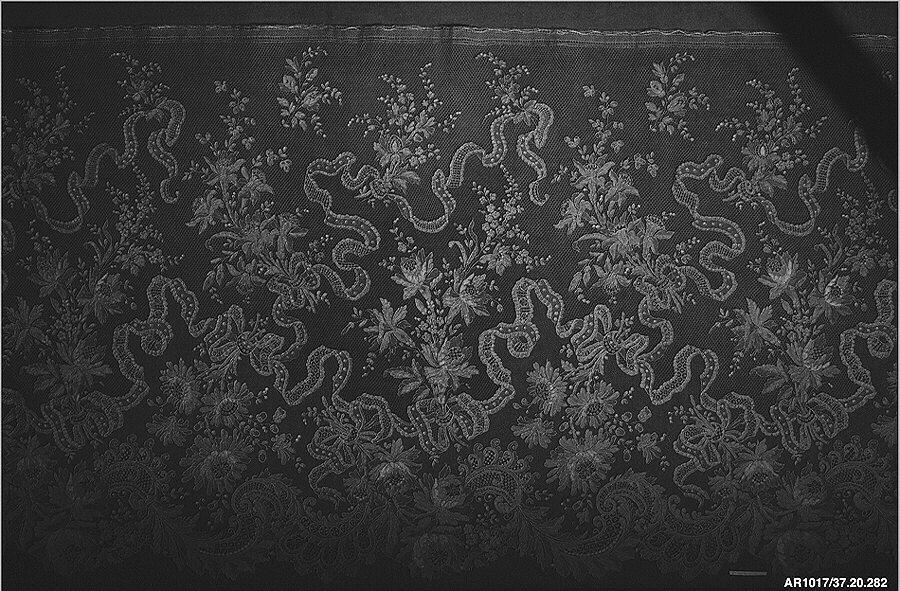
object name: flounce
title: Flounce (one of a pair)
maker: georges martin (compagnie des indes)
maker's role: maker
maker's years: 1800-1900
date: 1801-1900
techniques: lace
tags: flowers